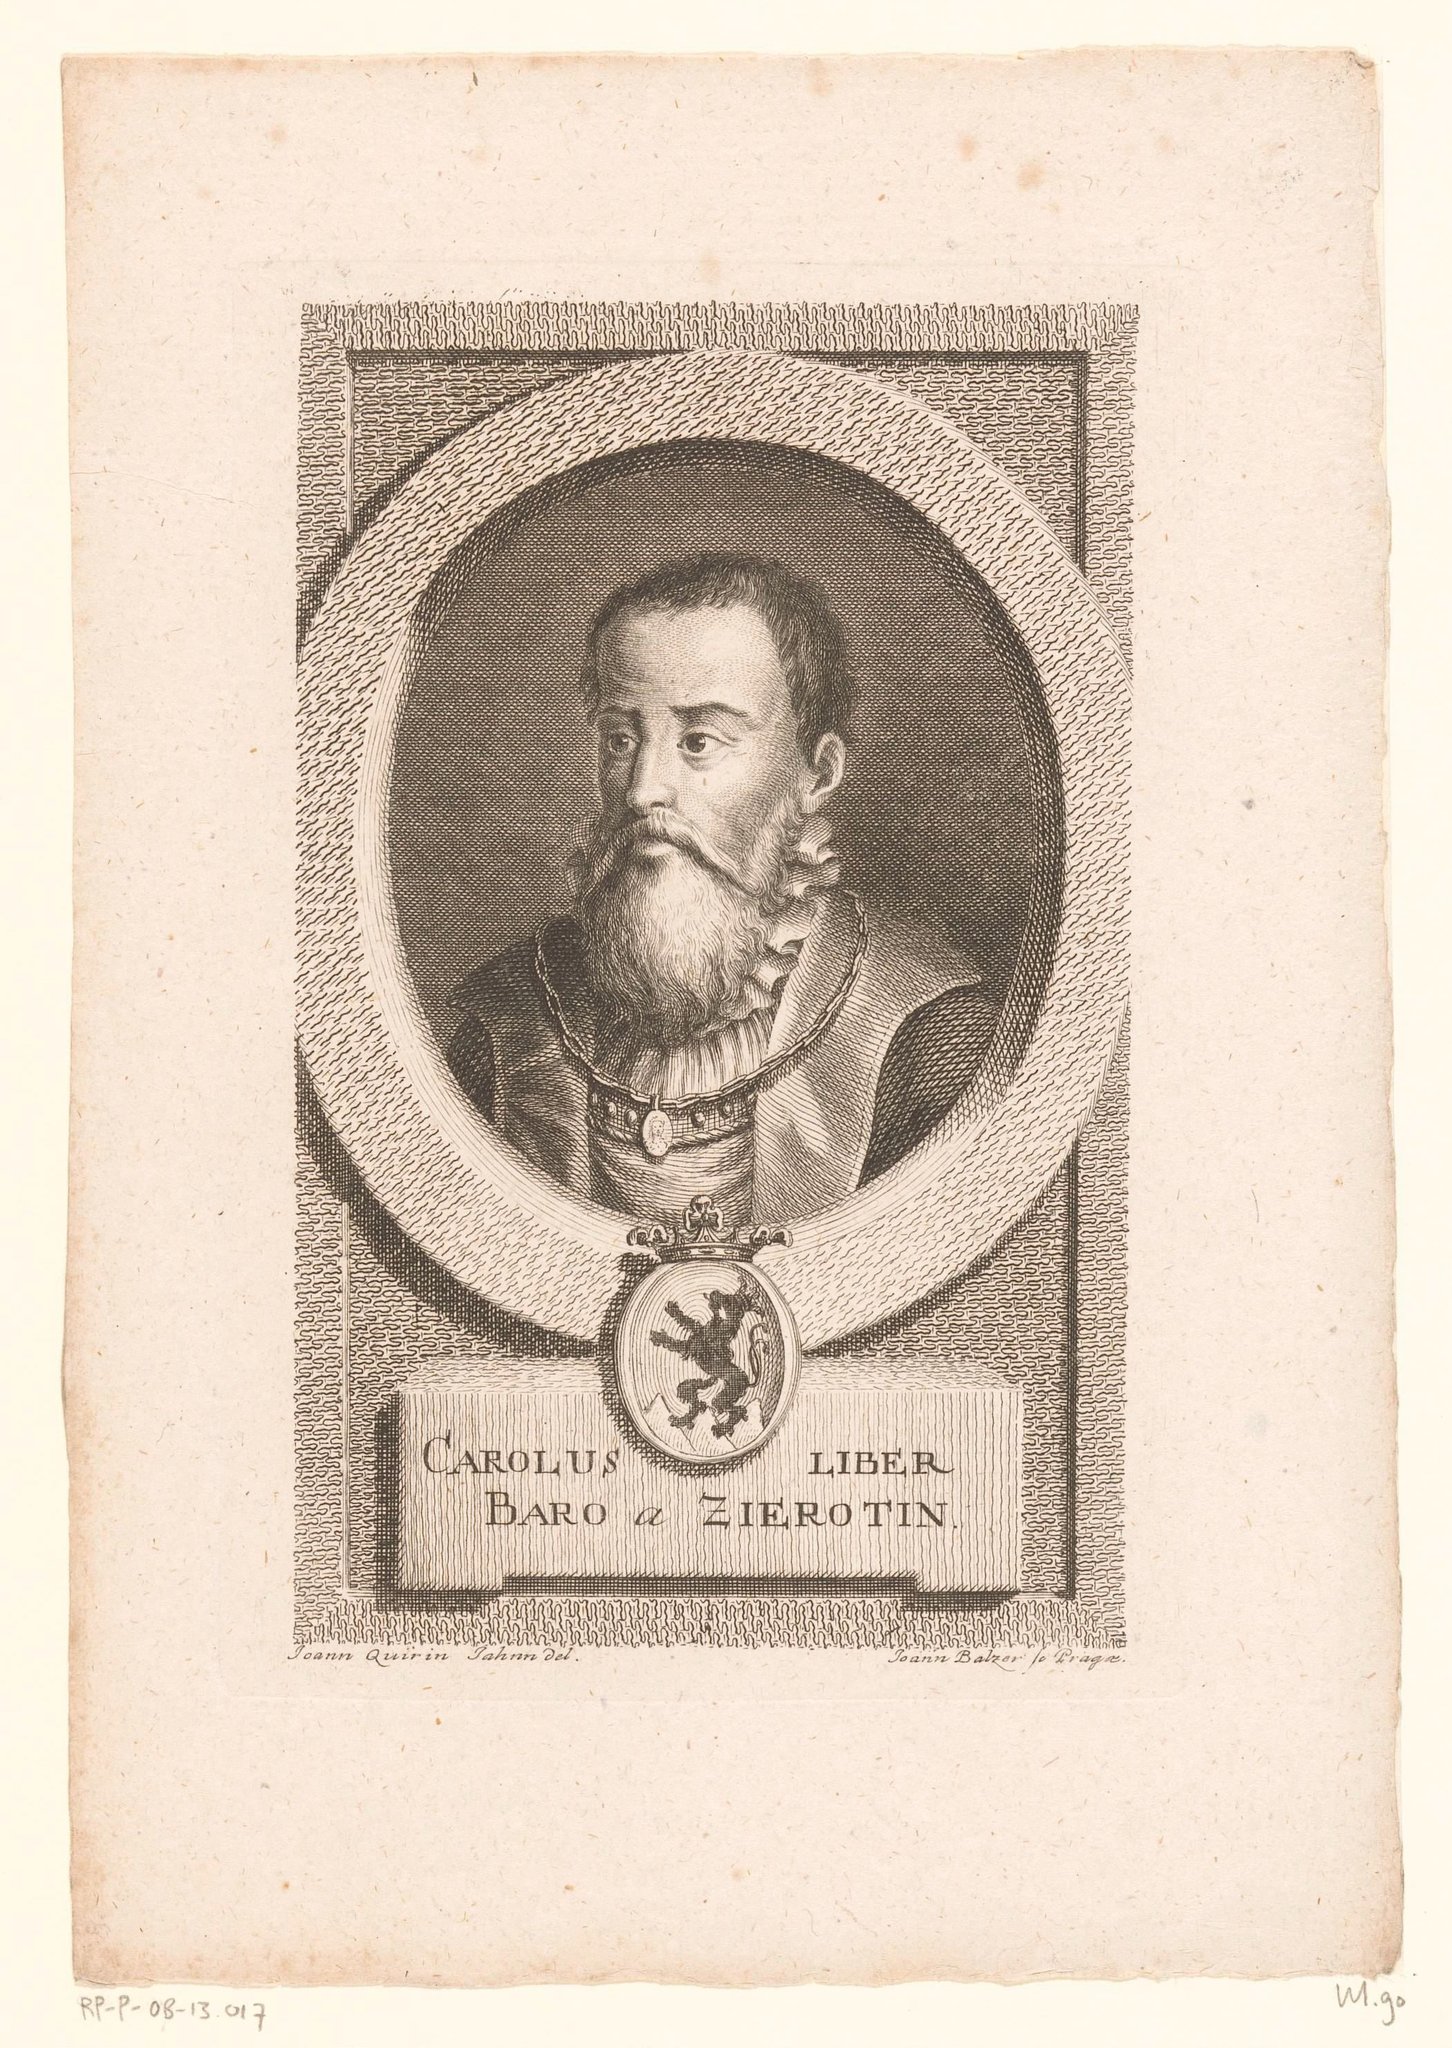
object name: print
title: Portret van Carl von Zierotin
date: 1749-1799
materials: paper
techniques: engraving, etching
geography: prague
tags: historical persons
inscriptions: collector's mark: Lugt 2228